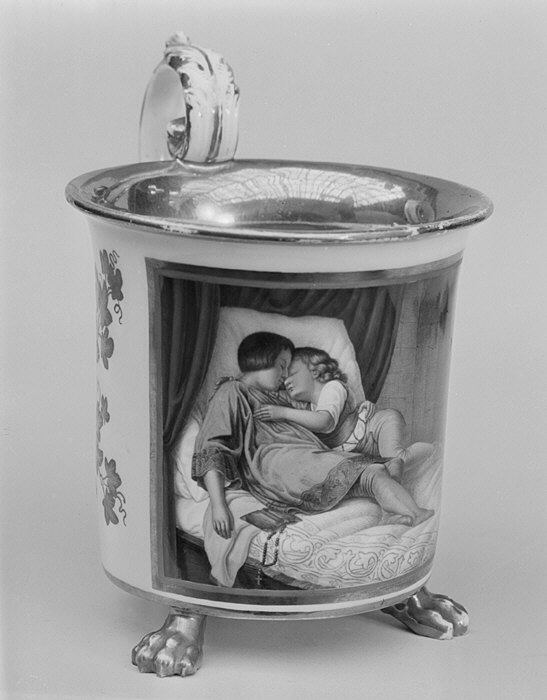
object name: cup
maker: meissen manufactory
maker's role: manufactory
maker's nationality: german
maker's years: 1710-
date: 1801-1900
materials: porcelain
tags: sleeping,children